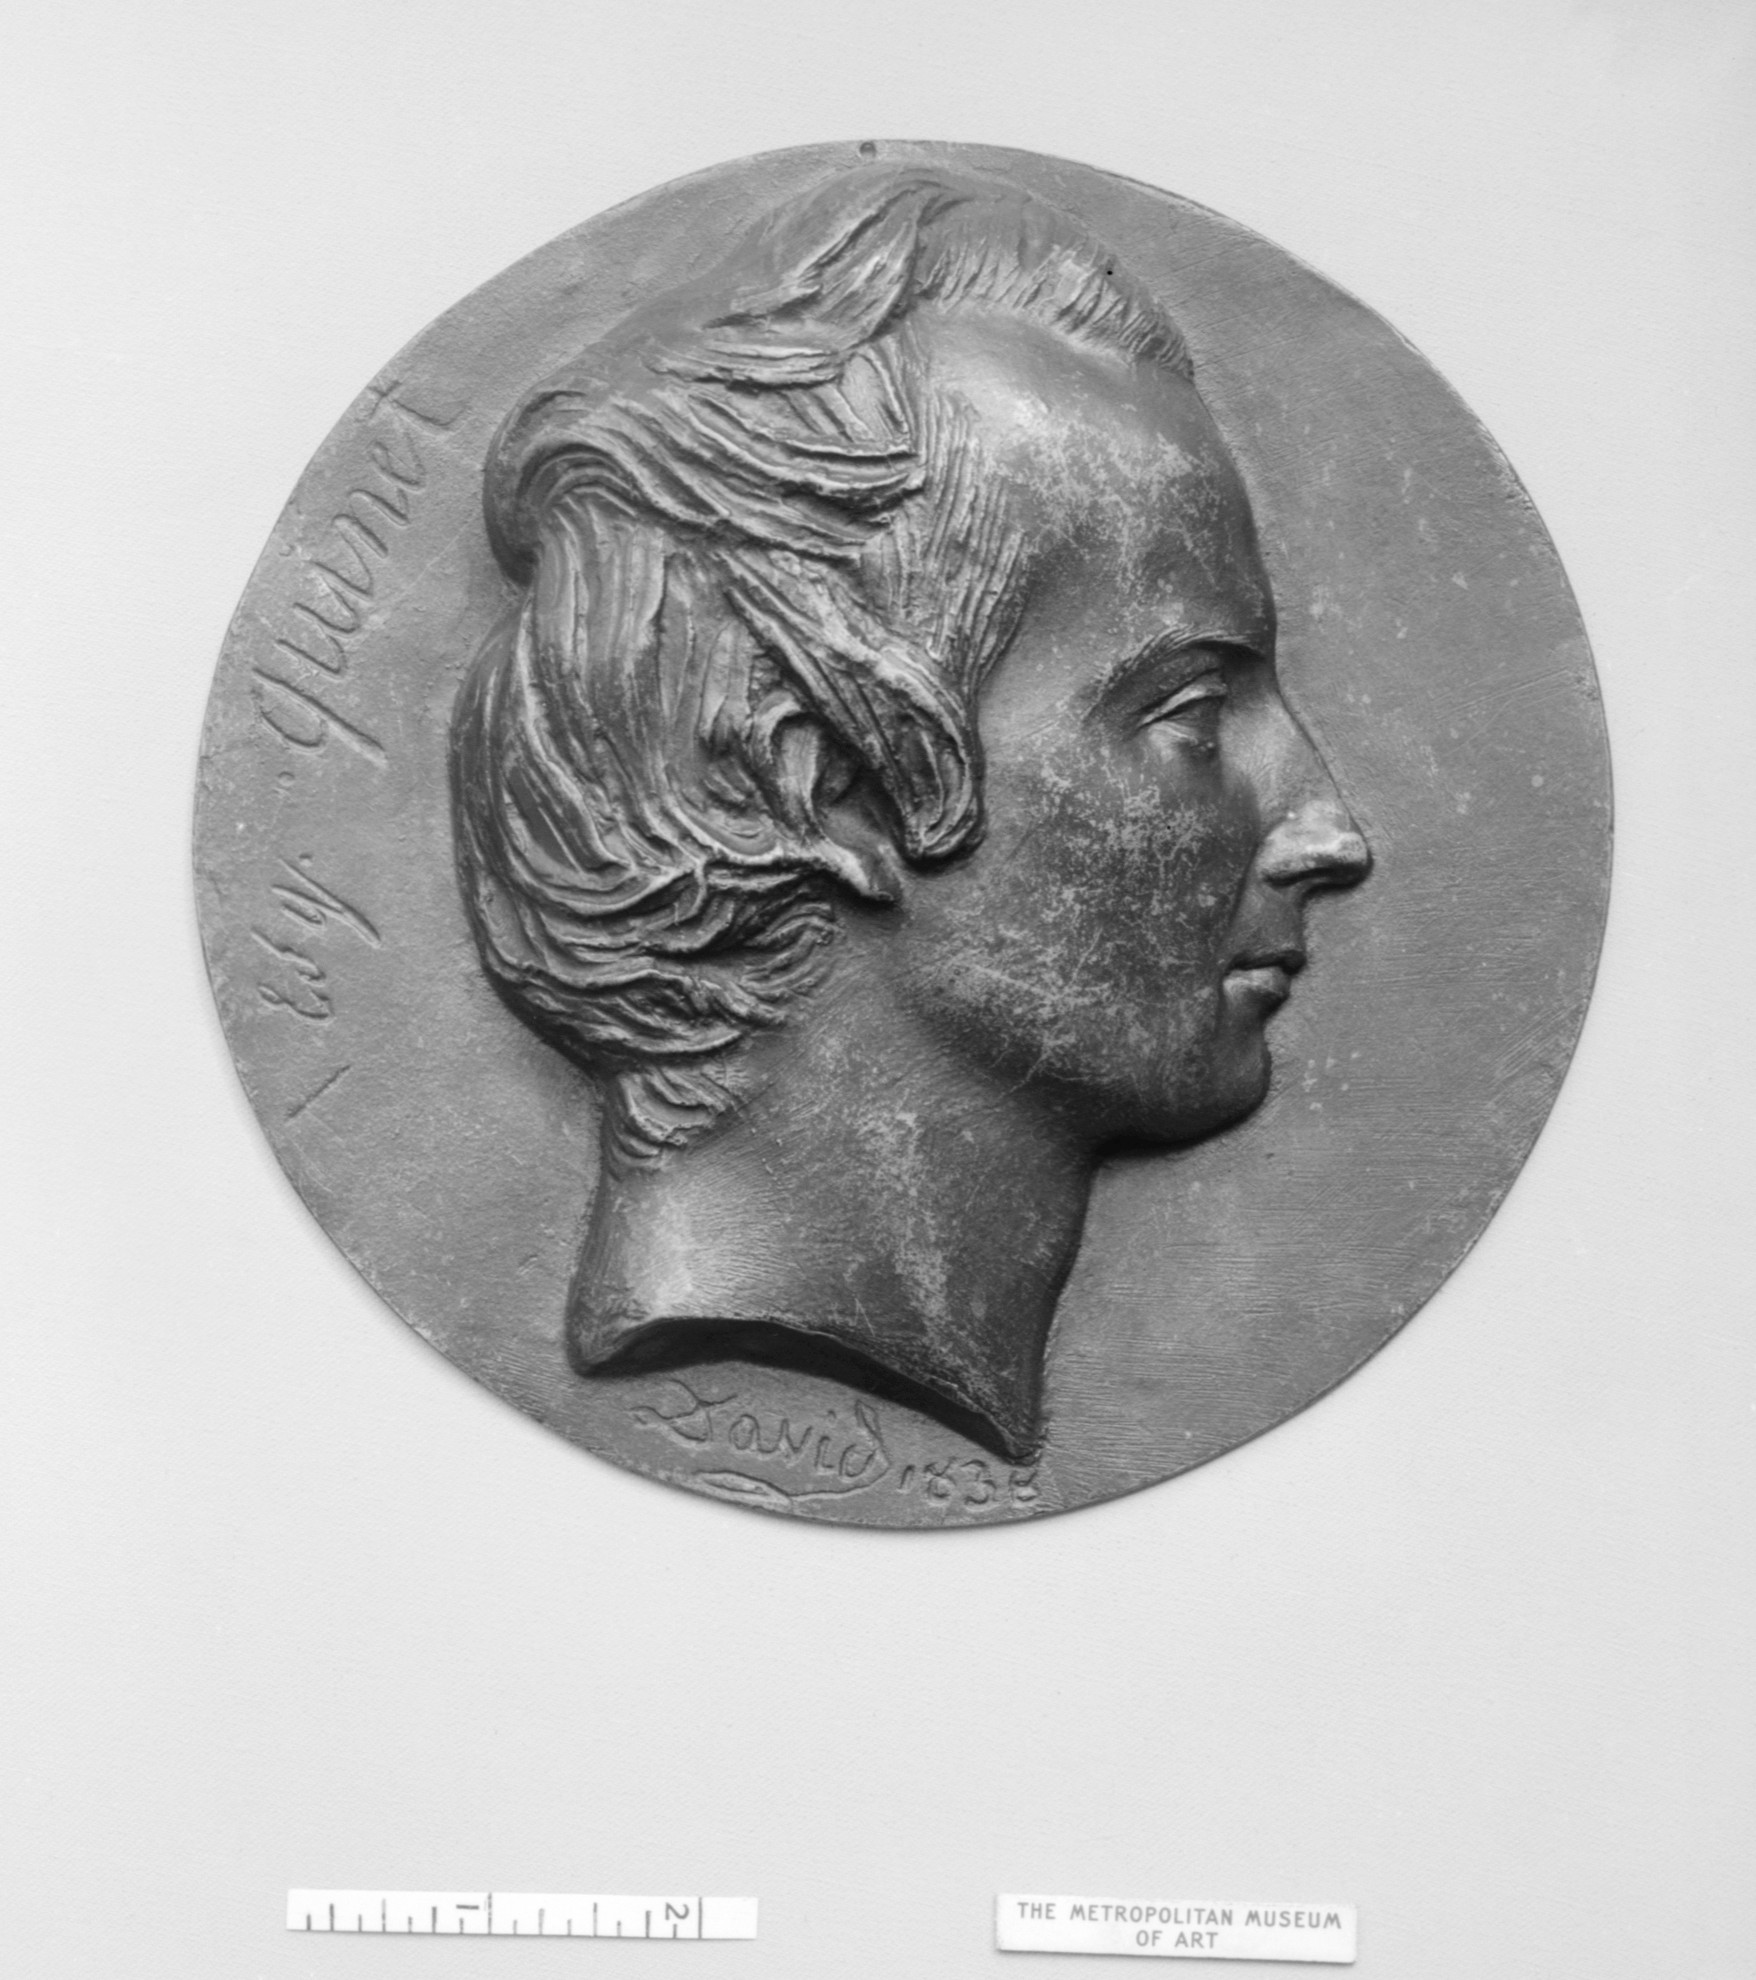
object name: medallion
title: Edgar Quinet (1803–1875), French poet and political writer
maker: pierre jean david d'angers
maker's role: artist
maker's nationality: french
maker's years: 1788-1856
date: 1838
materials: bronze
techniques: casting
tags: men,profiles,poets